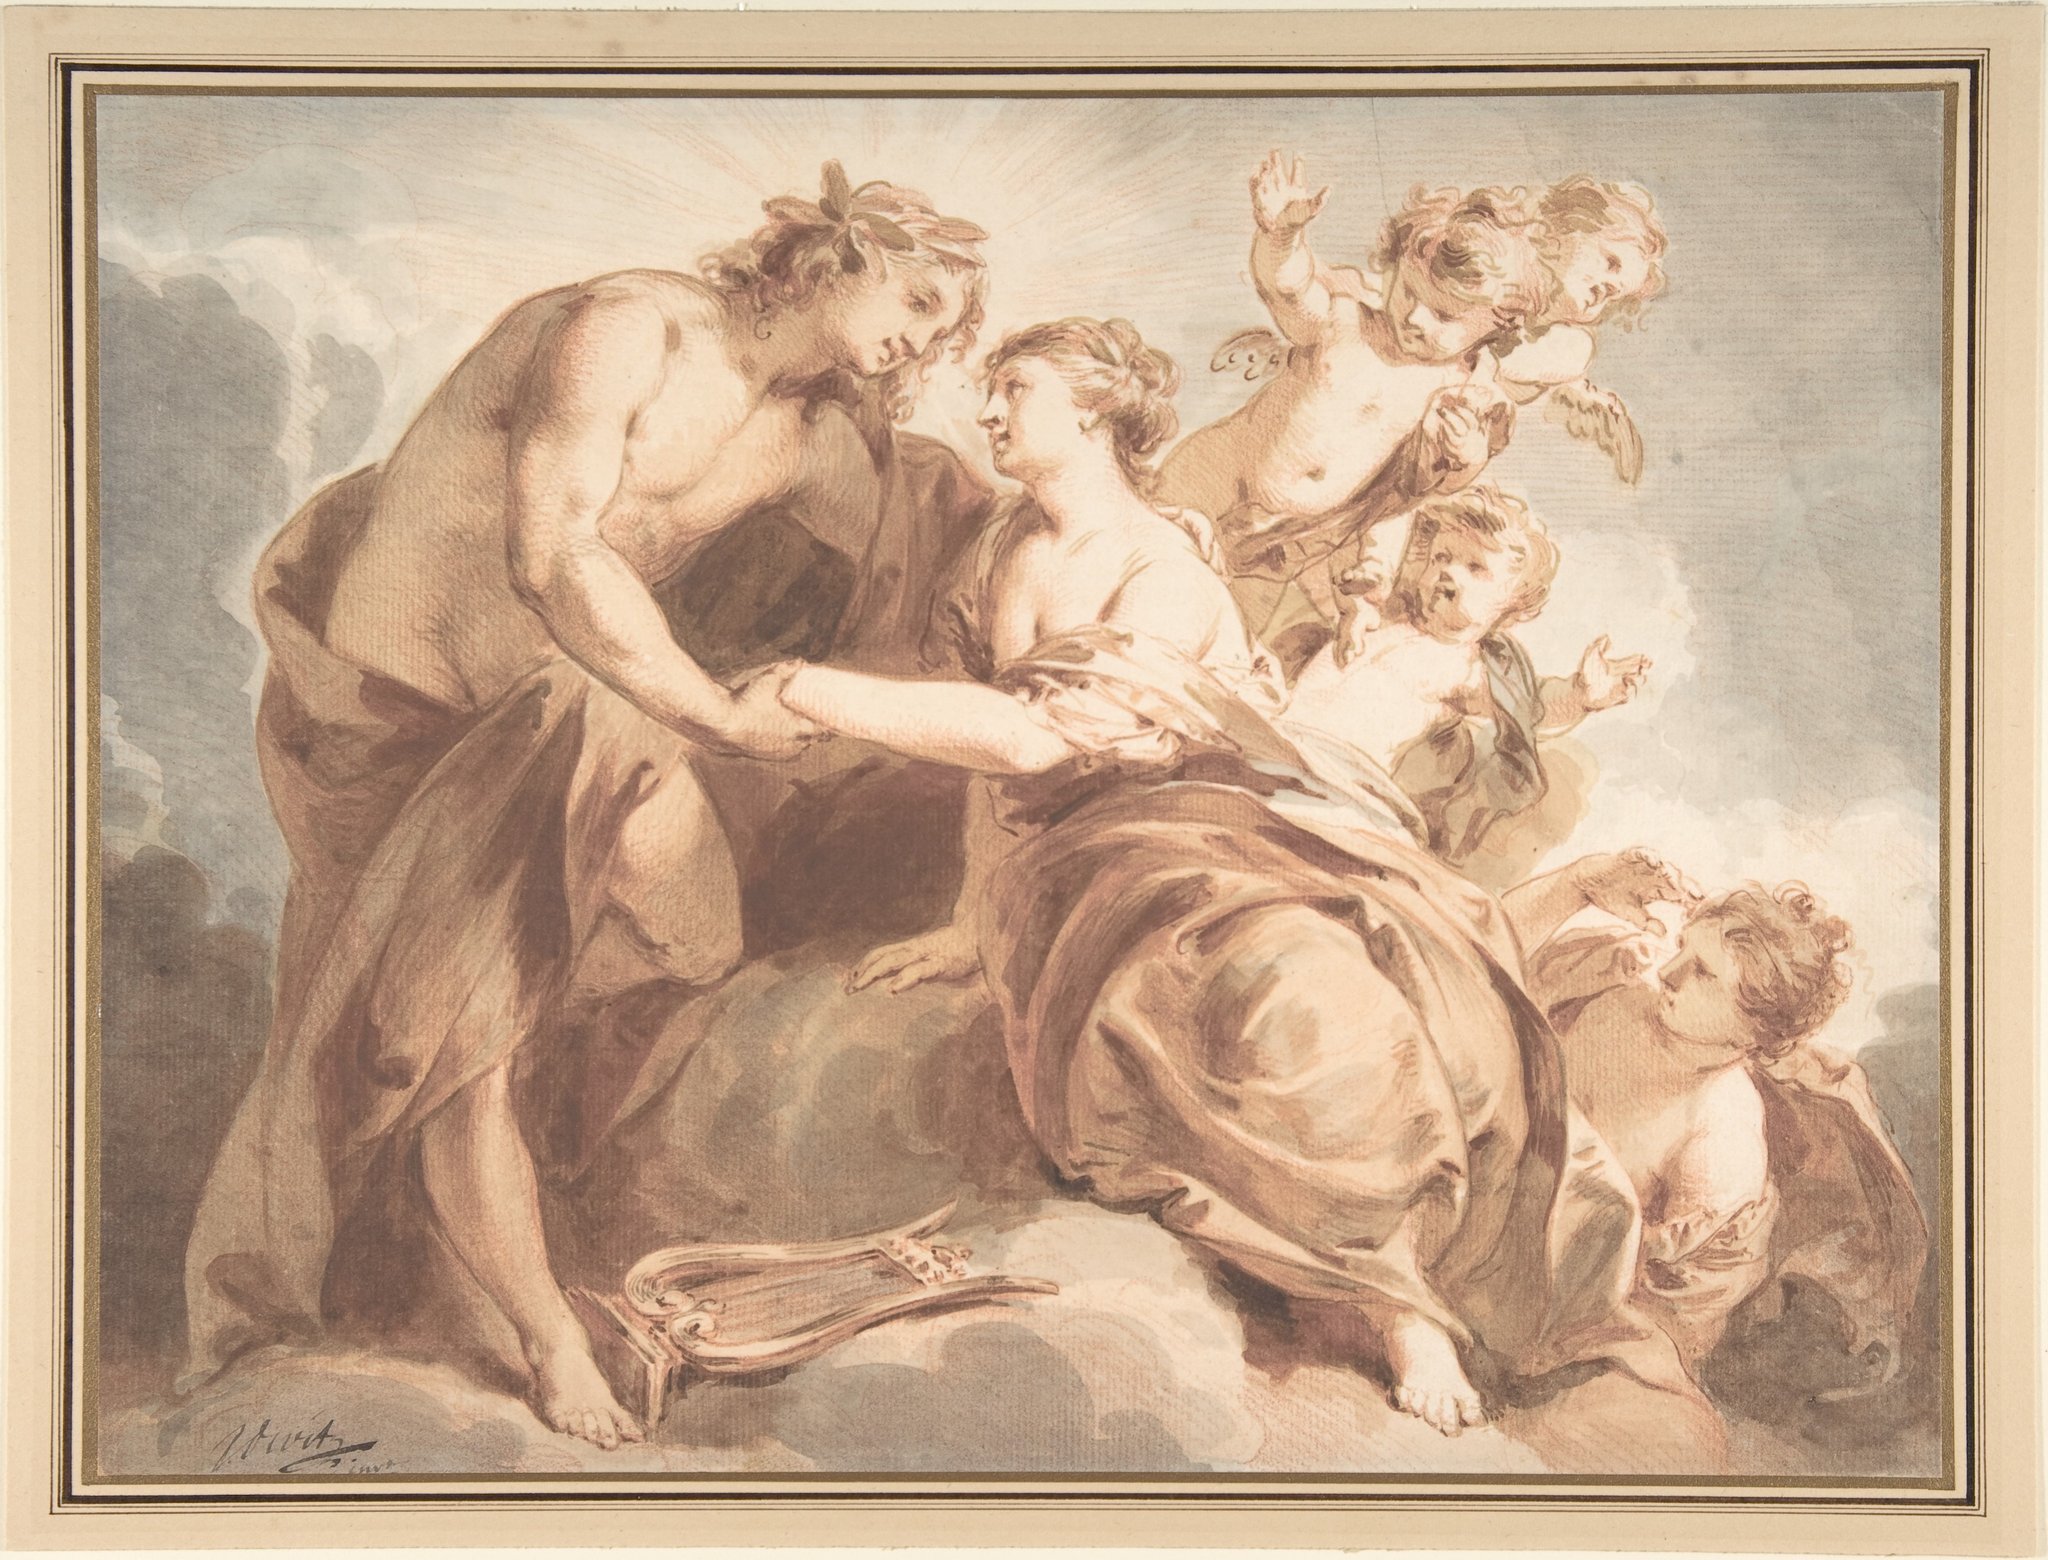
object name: drawing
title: Apollo and Thetis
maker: jacob de wit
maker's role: artist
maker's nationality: dutch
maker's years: 1695-1754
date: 1701-1733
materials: chalk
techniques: wash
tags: women,apollo,putti